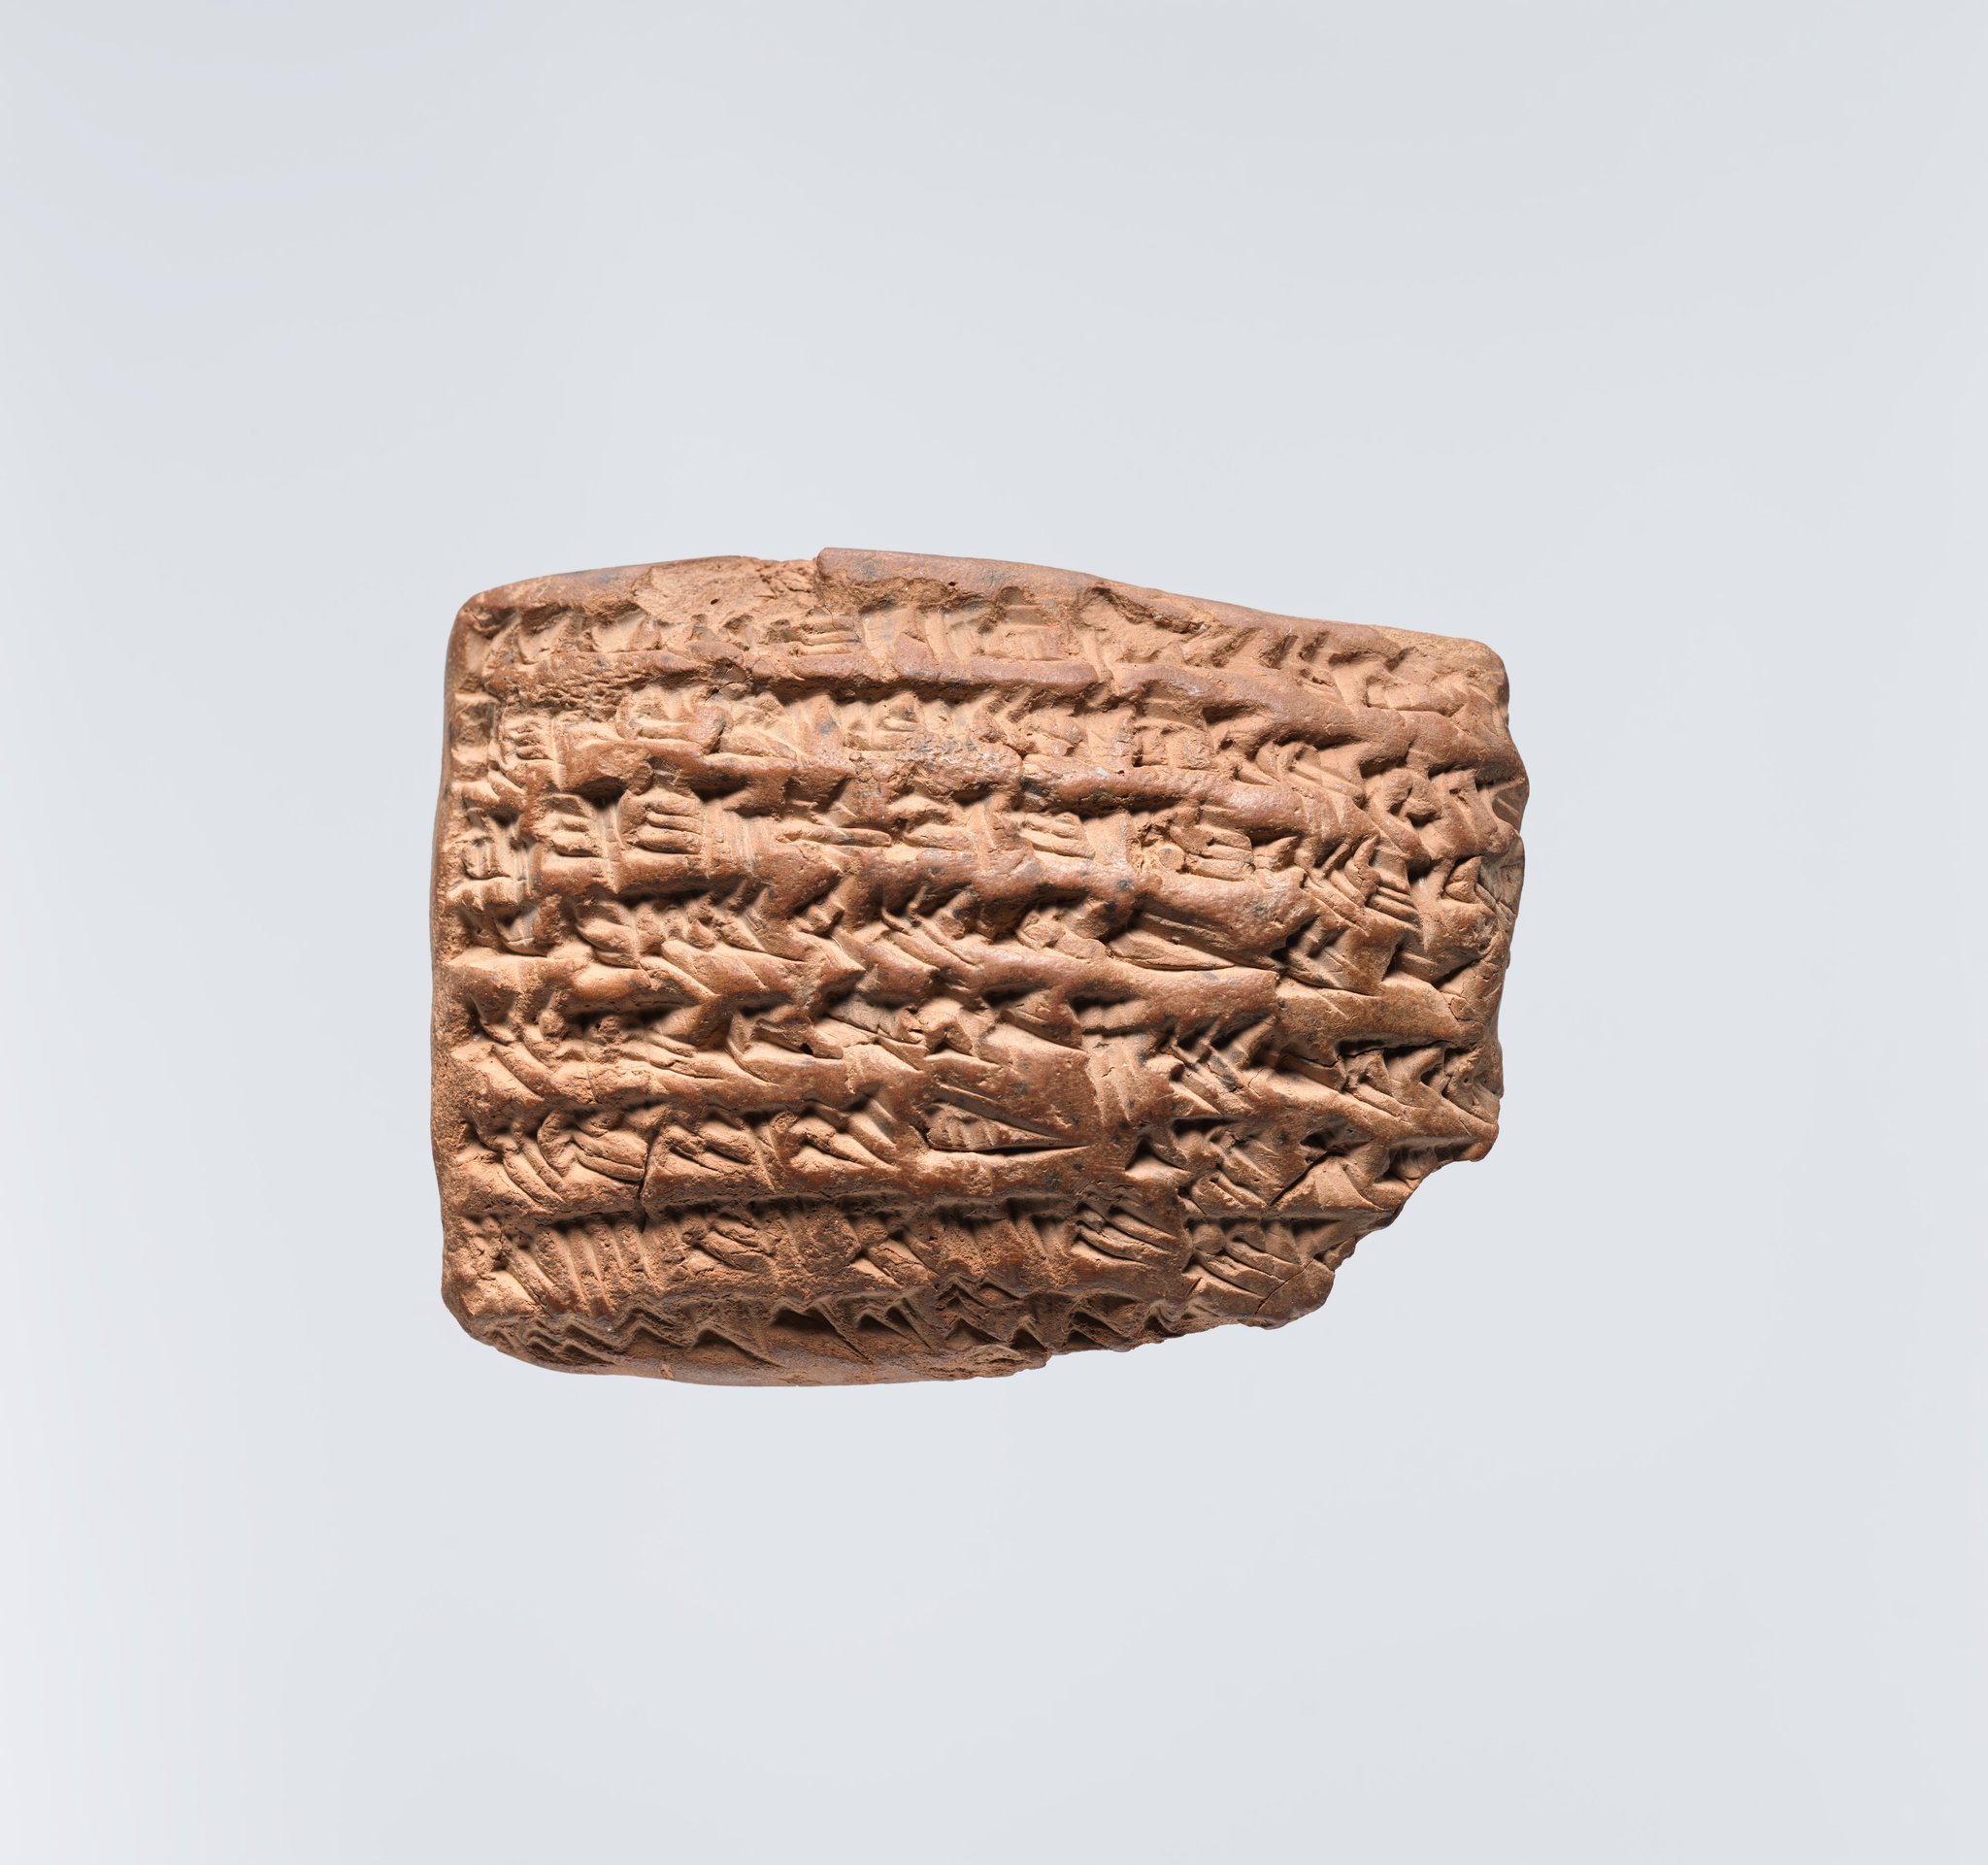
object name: cuneiform tablet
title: Cuneiform tablet: Gula incantation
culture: achaemenid or babylonian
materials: clay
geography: mesopotamia